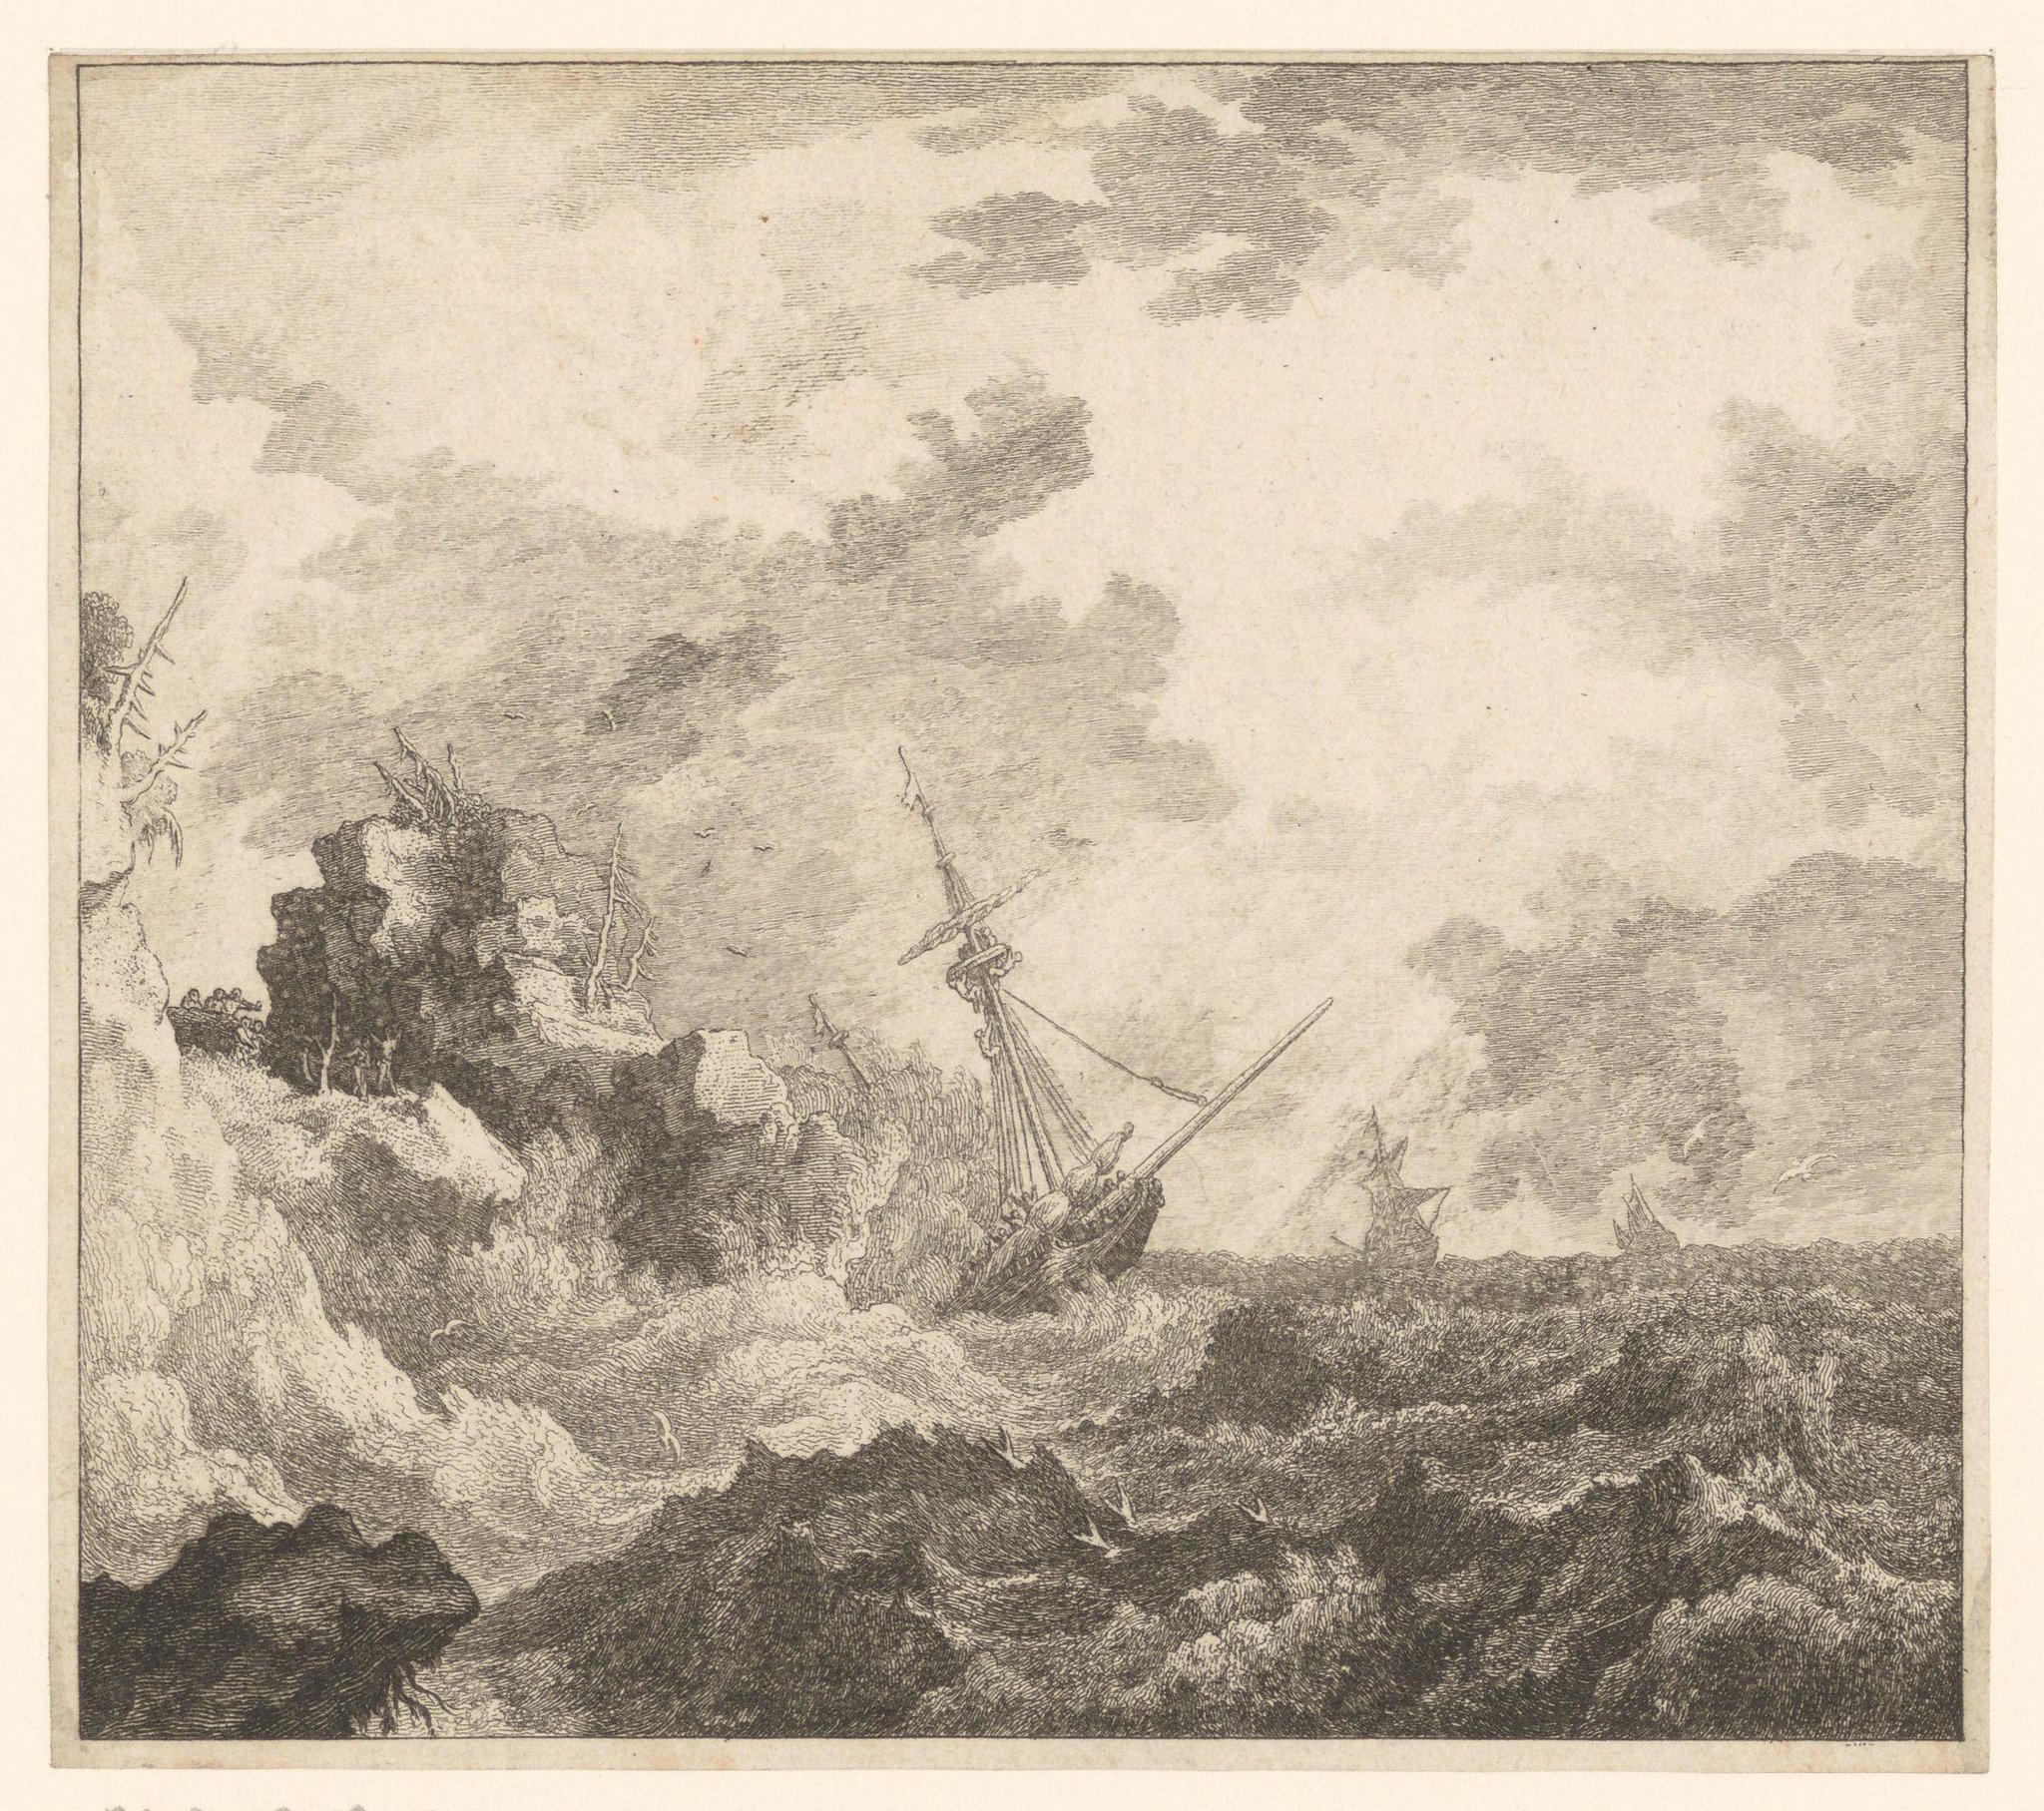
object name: print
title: Schepen in noodweer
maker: francis place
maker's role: print maker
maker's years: 1647-1728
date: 1657-1728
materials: paper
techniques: etching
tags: sailing-ship, sailing-boat, storm at sea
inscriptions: collector's mark: Lugt 2228